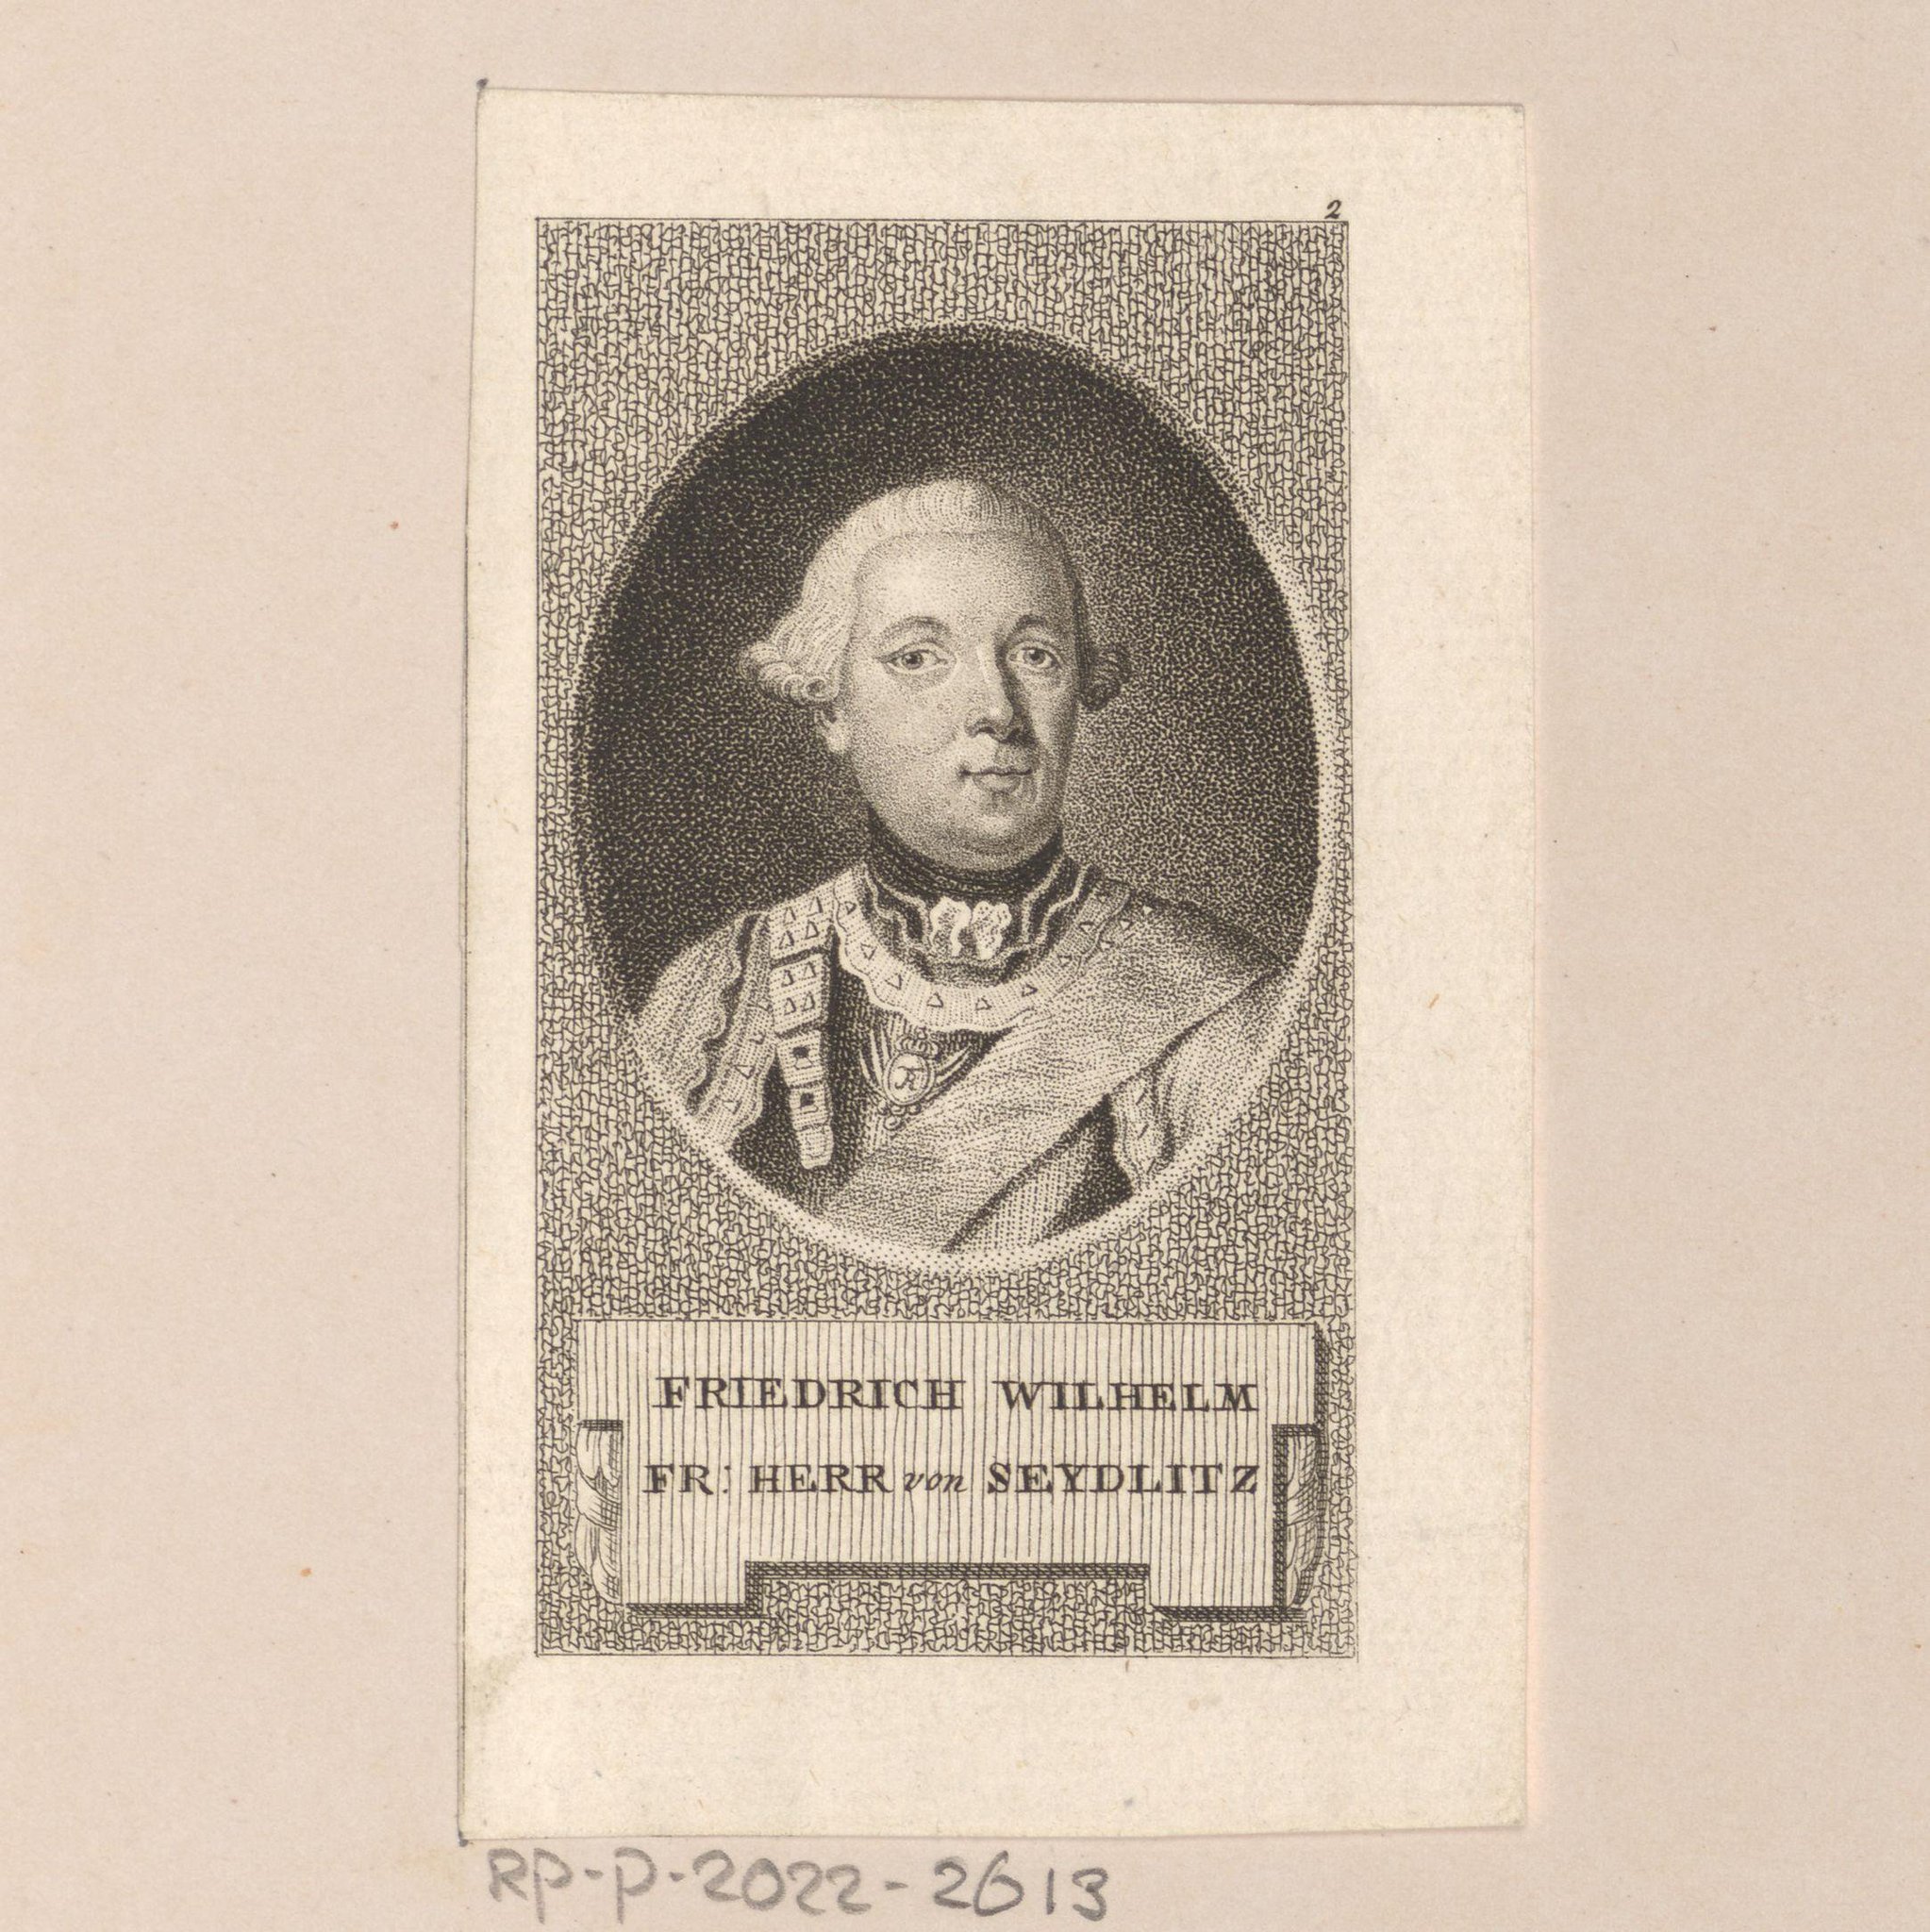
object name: print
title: Portret van Friedrich Wilhelm von Seydlitz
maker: daniel berger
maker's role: print maker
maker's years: 1744-1824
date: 1764-1824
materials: paper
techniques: etching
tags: commander-in-chief, general, marshal, historical persons